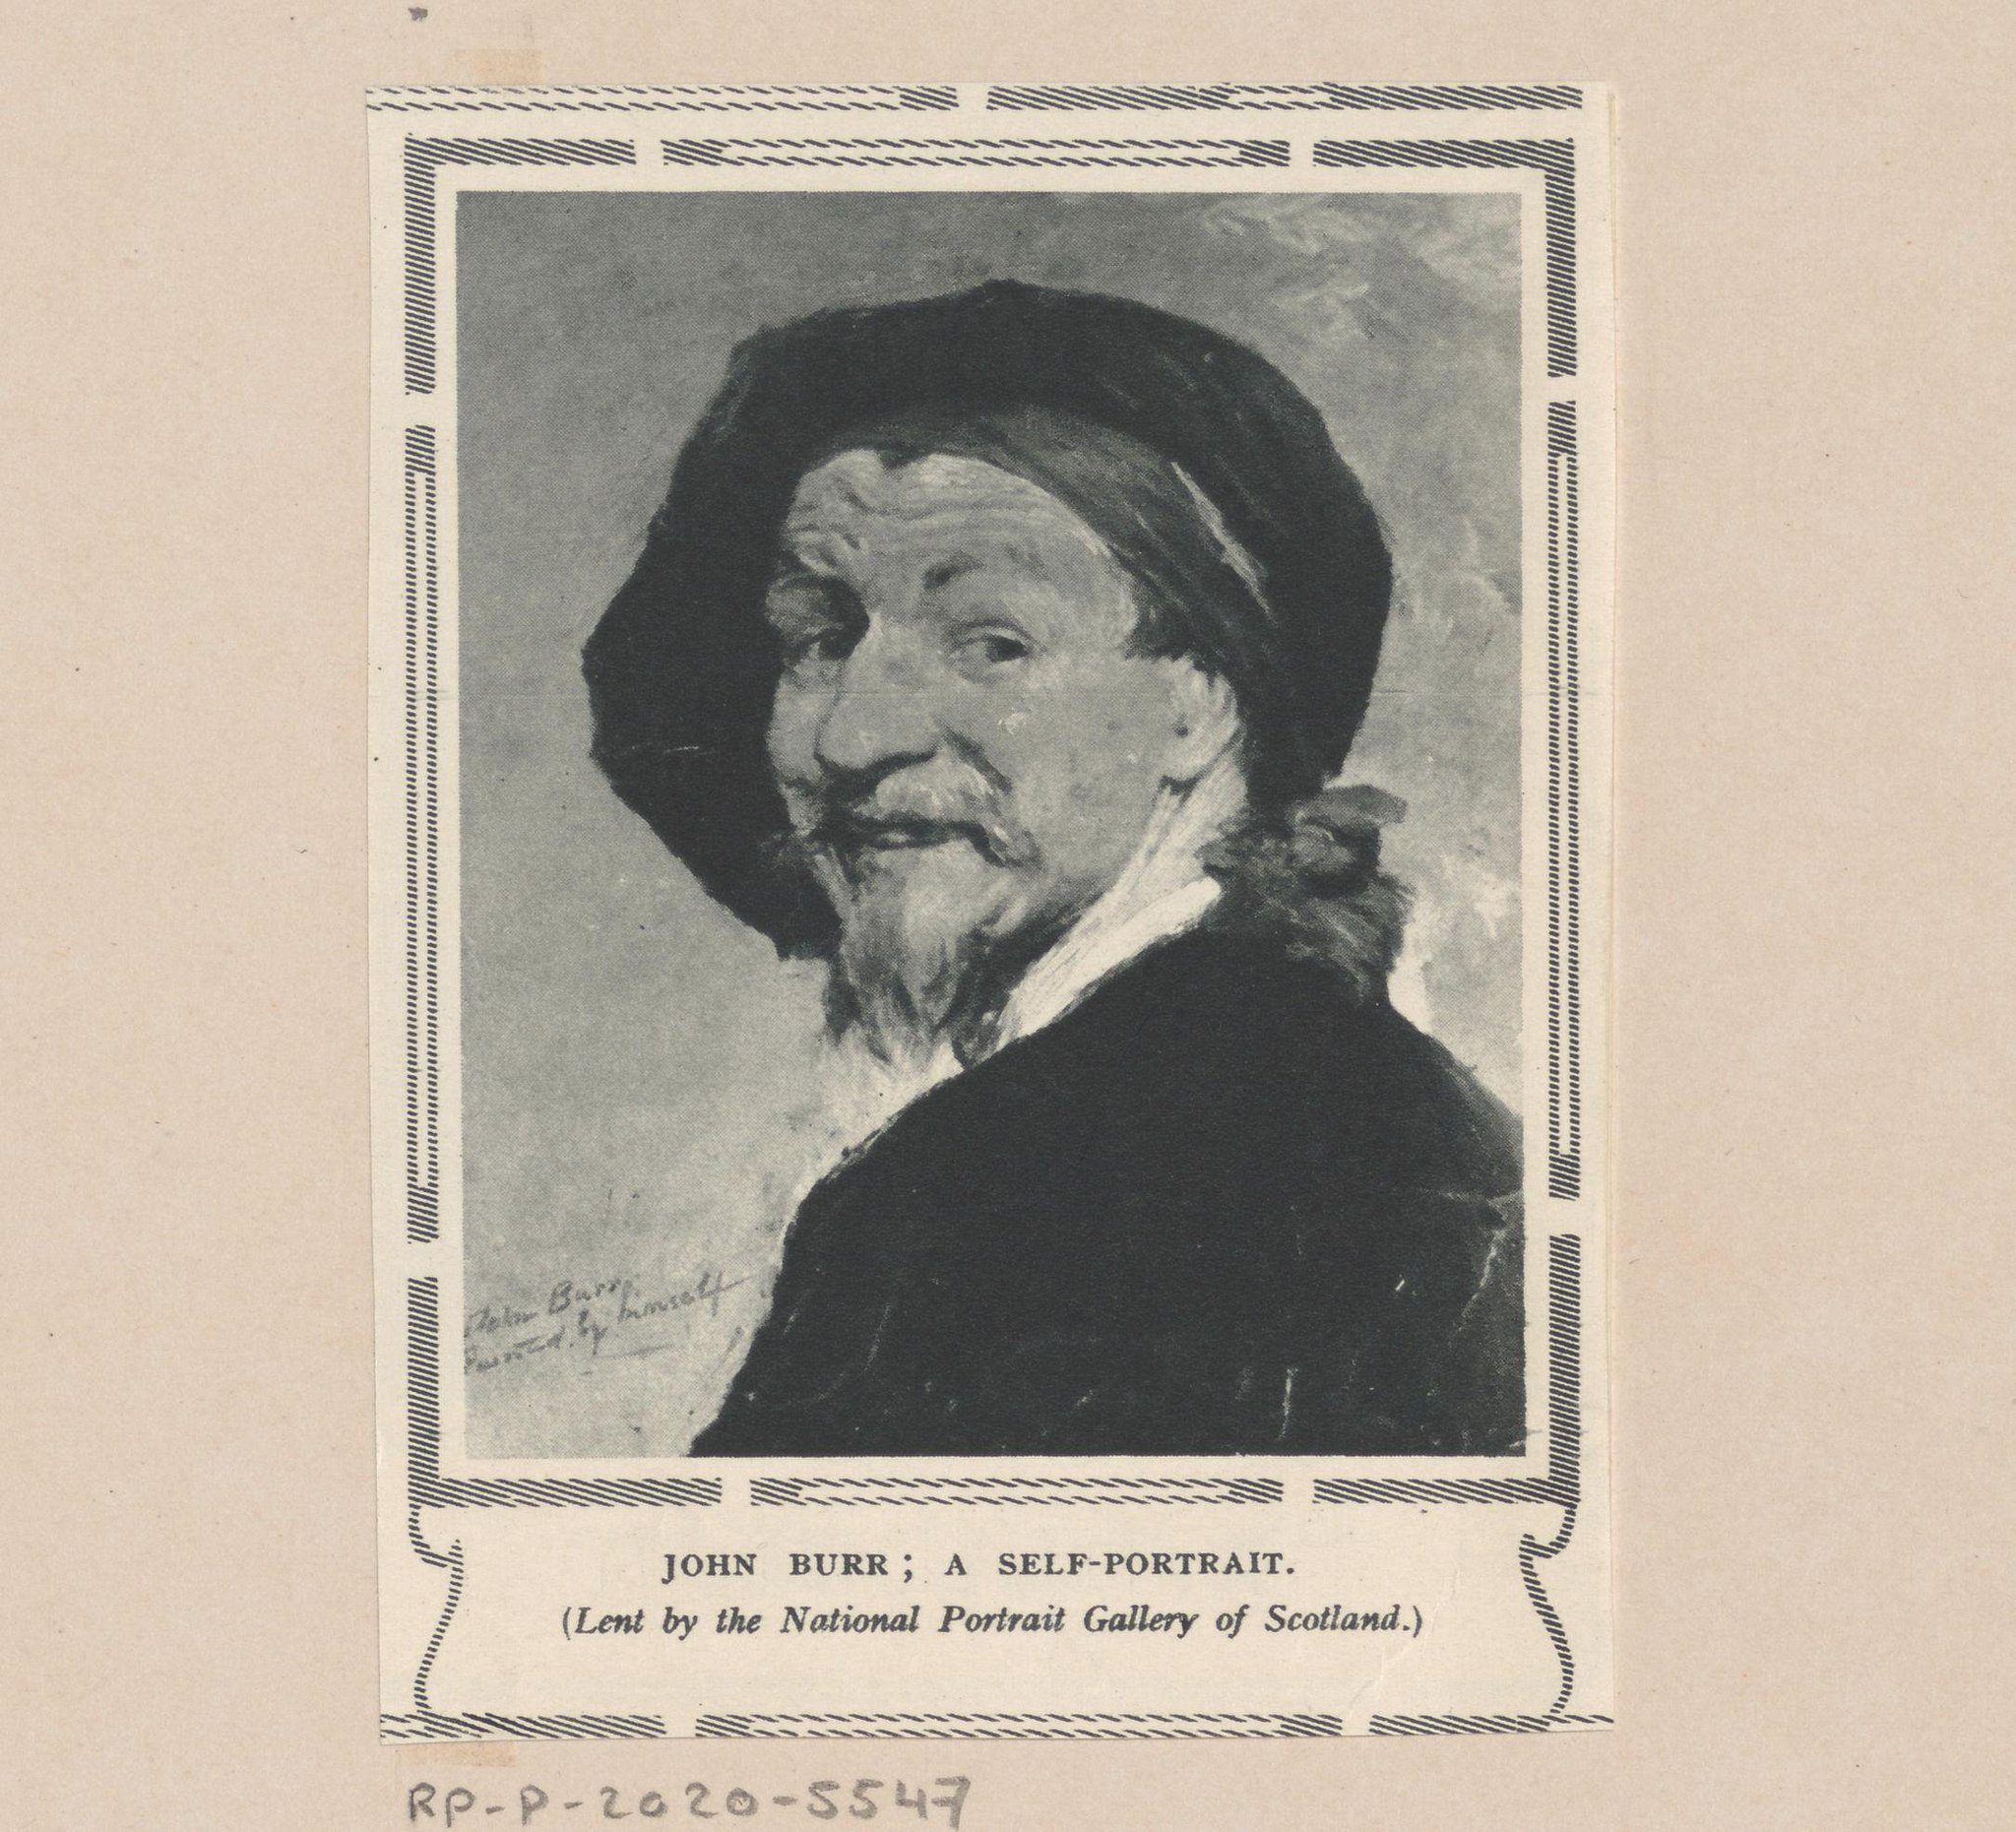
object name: photomechanical print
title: Portret van John Burr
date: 1930-1970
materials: paper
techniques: rotogravure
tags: london, painter, john burr, historical persons, portrait, self-portrait of painter